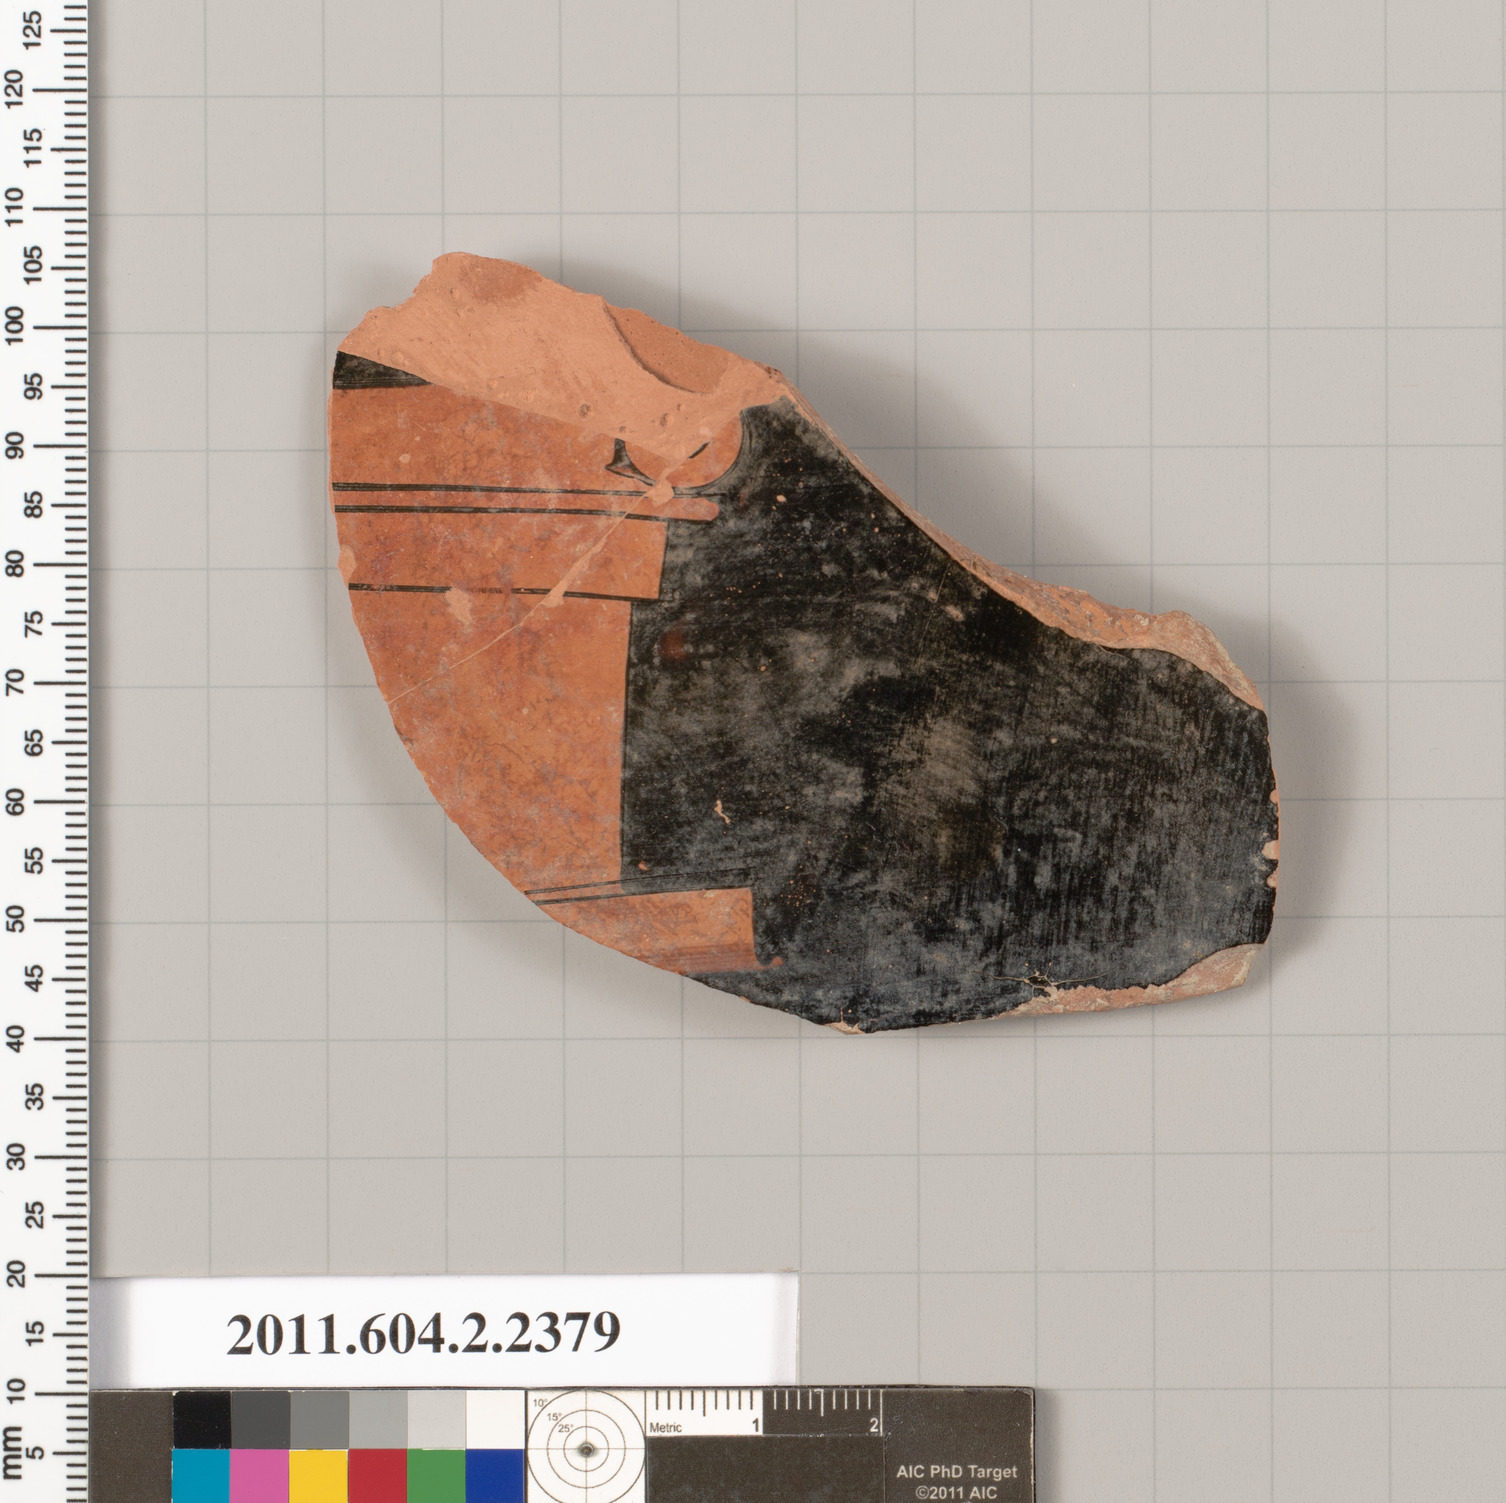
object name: pot fragment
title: Terracotta fragment of a pot; glazed on the inside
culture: greek, attic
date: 500-480 BCE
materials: terracotta